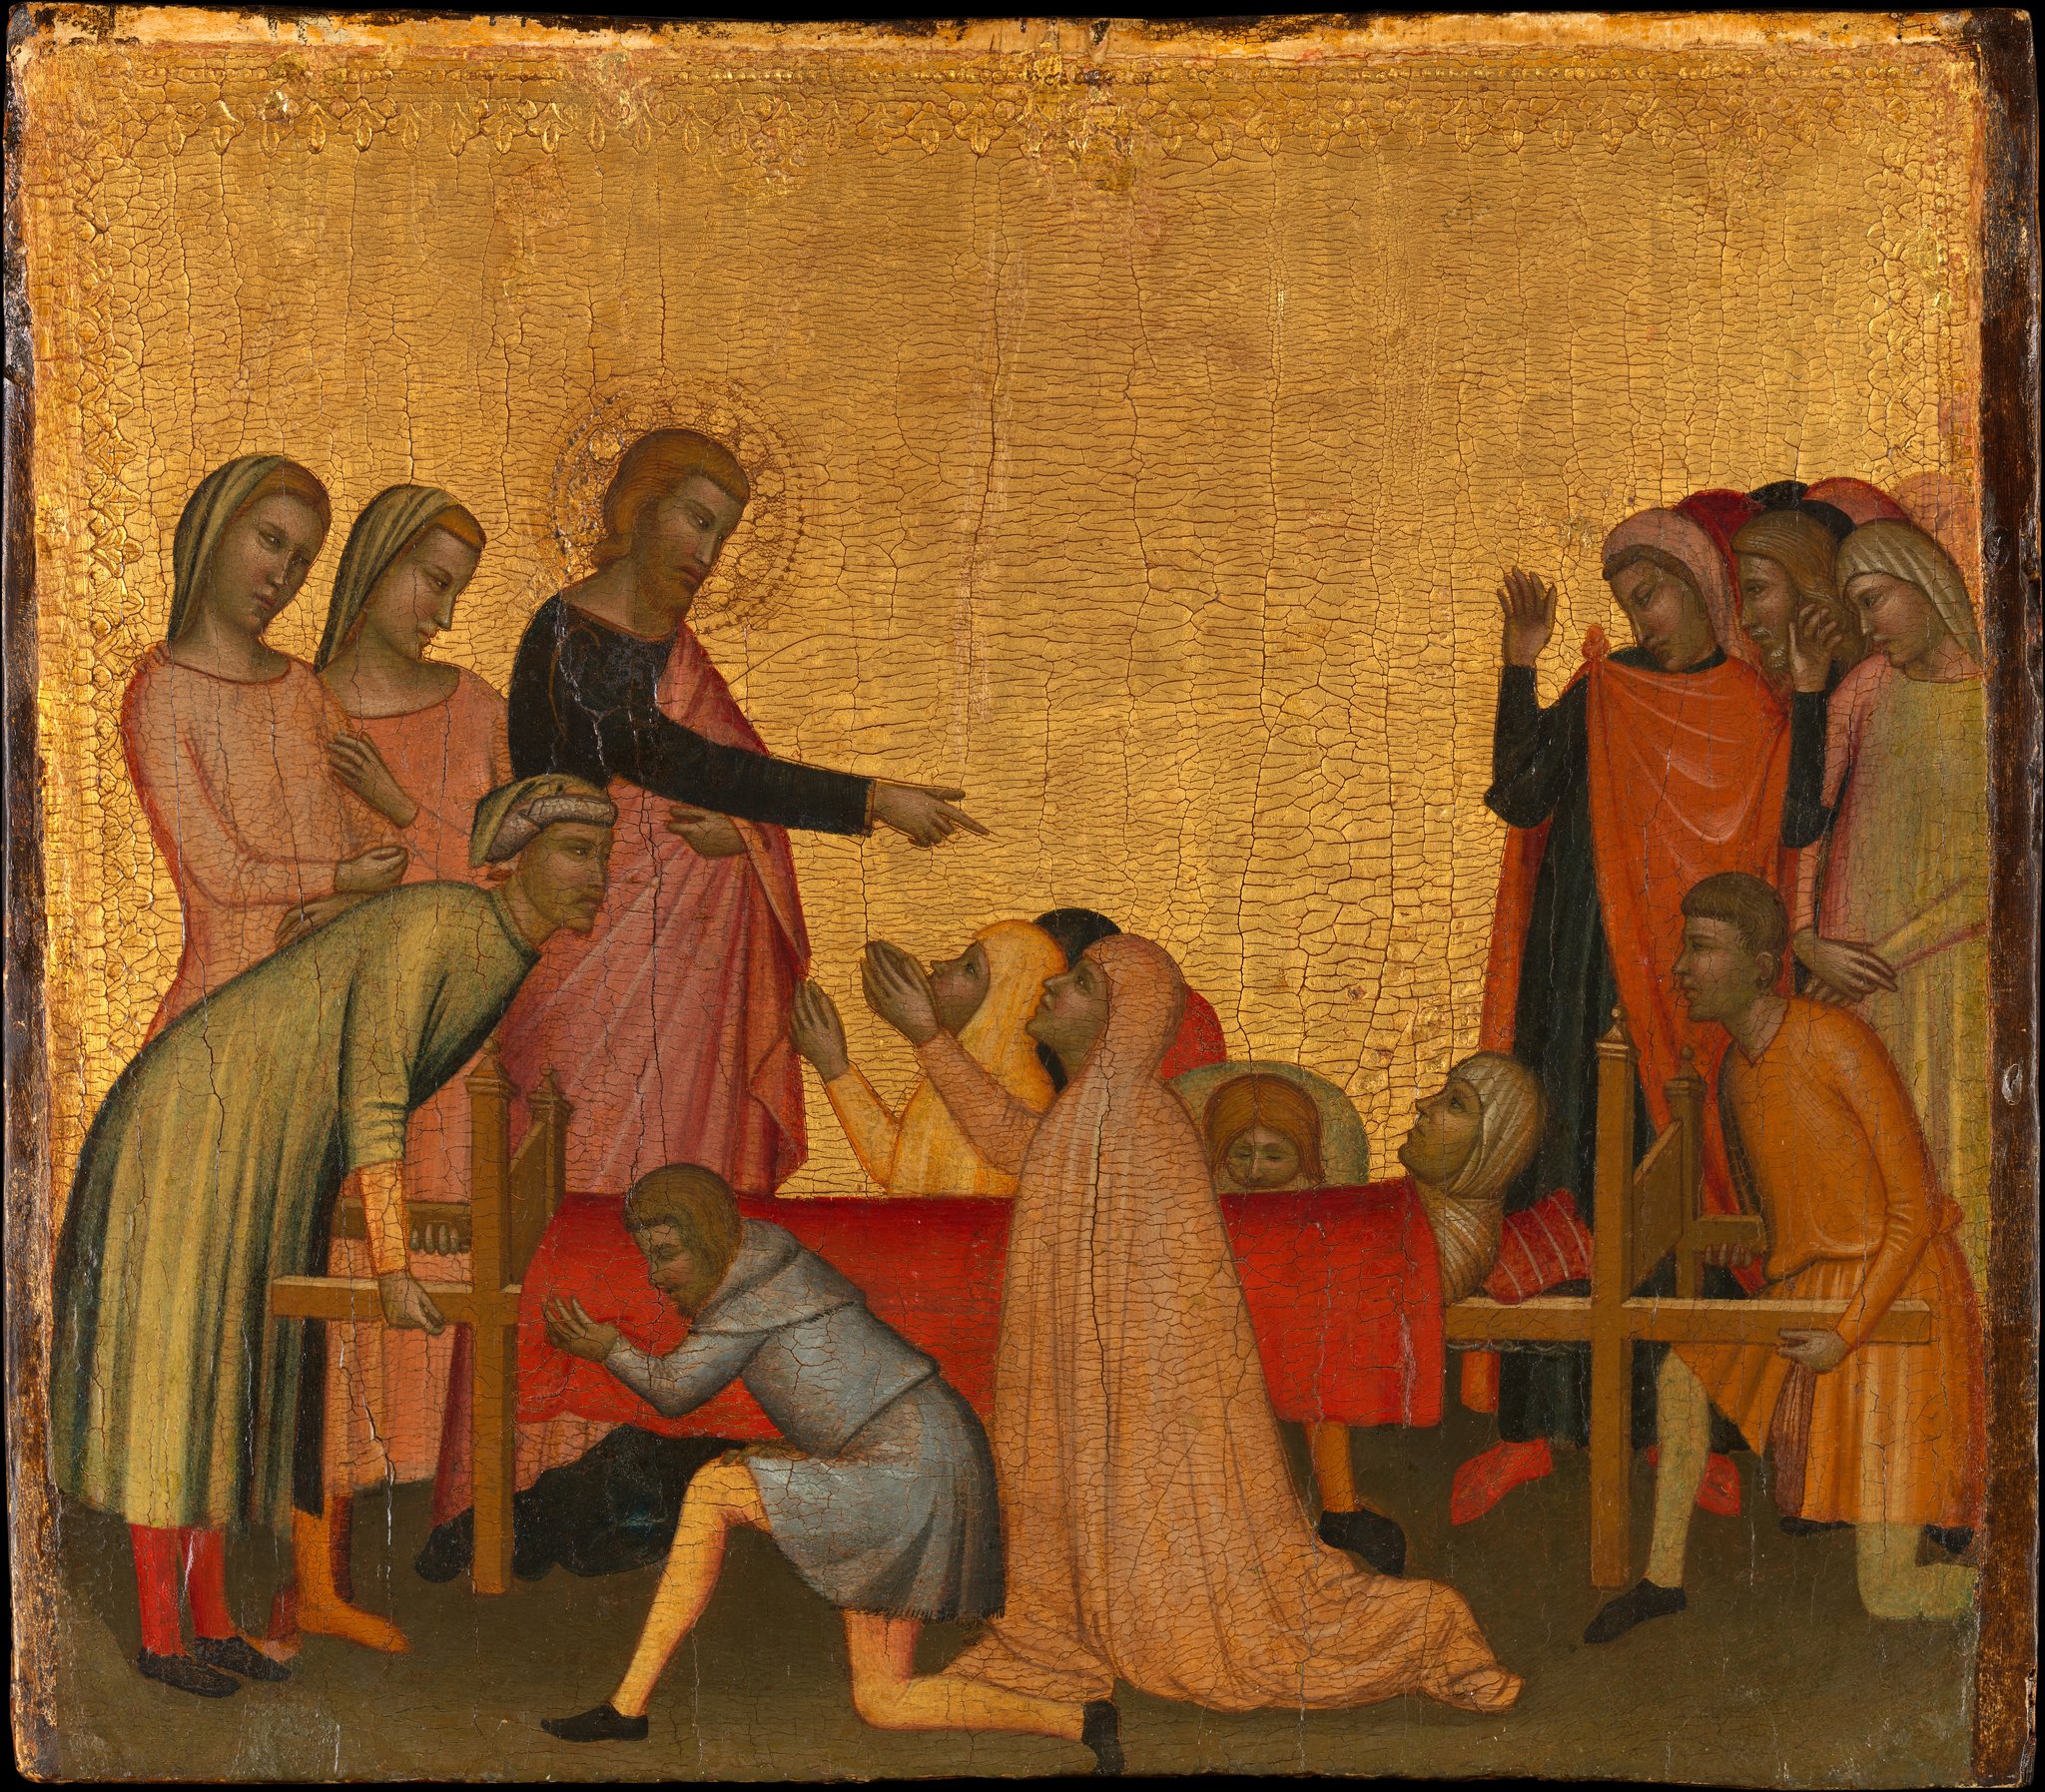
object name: painting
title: Saint John the Evangelist Raises Satheus to Life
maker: francescuccio ghissi (francesco di cecco ghissi)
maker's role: artist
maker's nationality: italian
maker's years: 1359-1374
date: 1370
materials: gold leaf, paint, wood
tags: men,women,saint john the evangelist